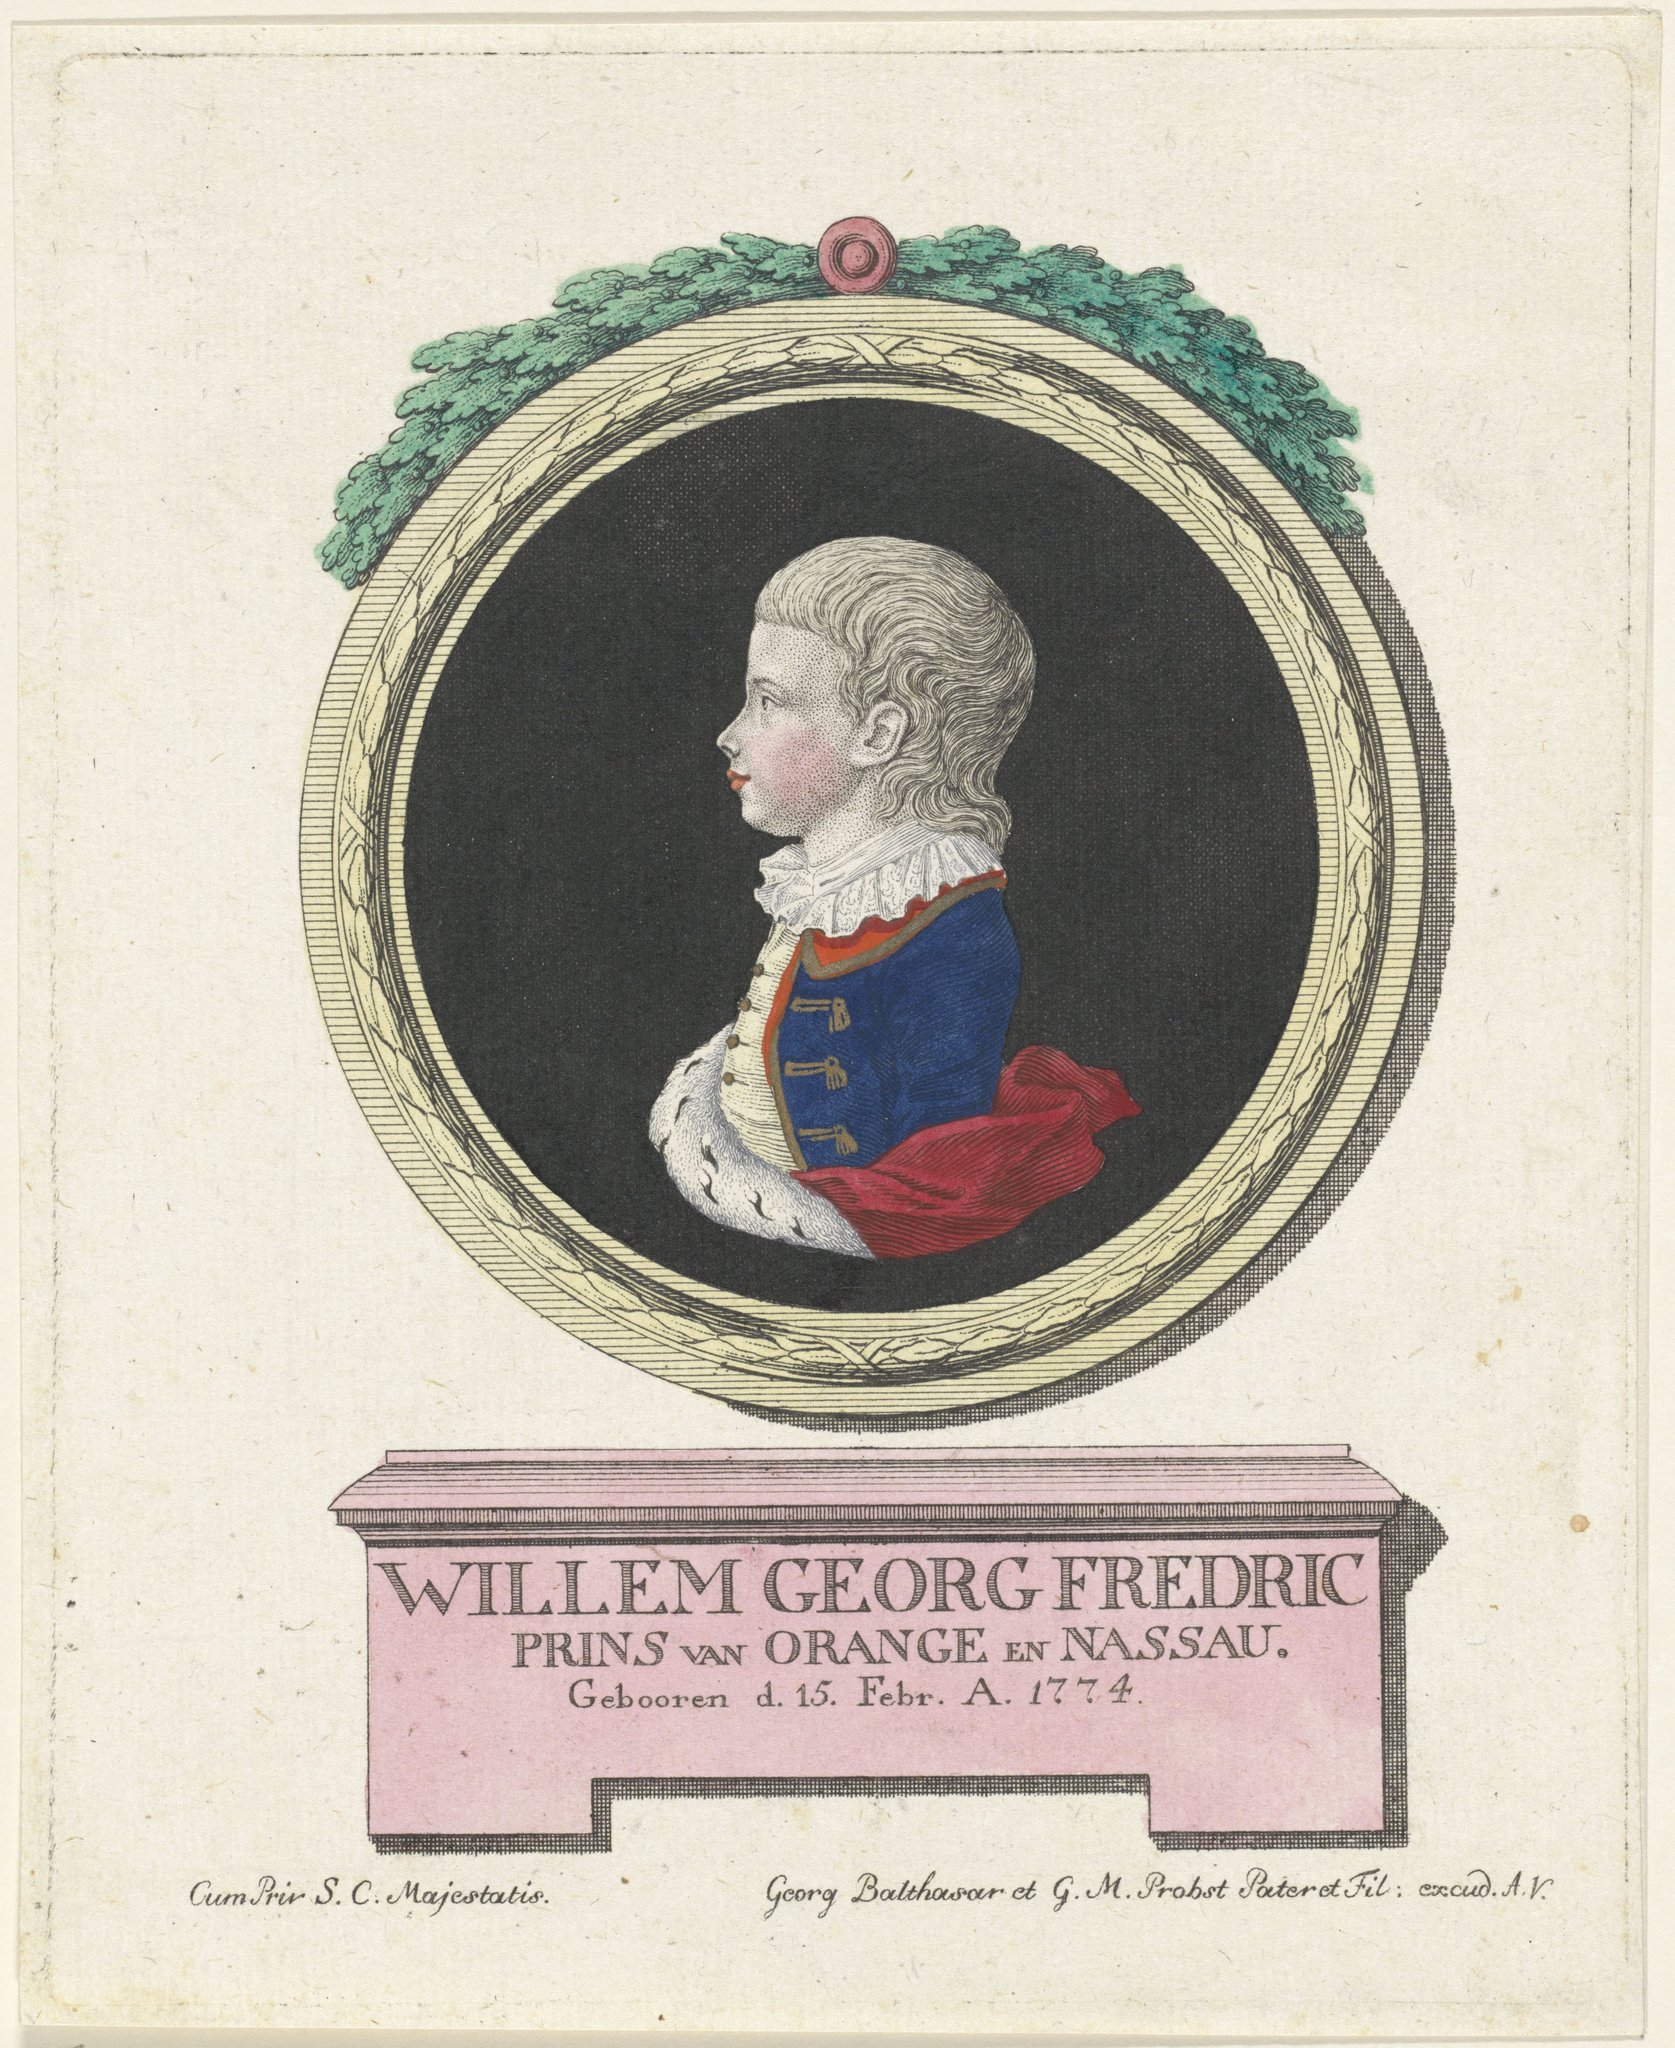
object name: print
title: Portret van Frederik, prins van Oranje-Nassau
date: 1780-1788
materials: paper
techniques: engraving, etching, hand coloring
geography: low countries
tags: the hague, willem george frederik (prins van oranje-nassau)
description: De hier vermelde titel verwijst naar de hoogst verkregen titel van de geportretteerde, niet per se naar de titel die de geportretteerde op deze voorstelling draagt.